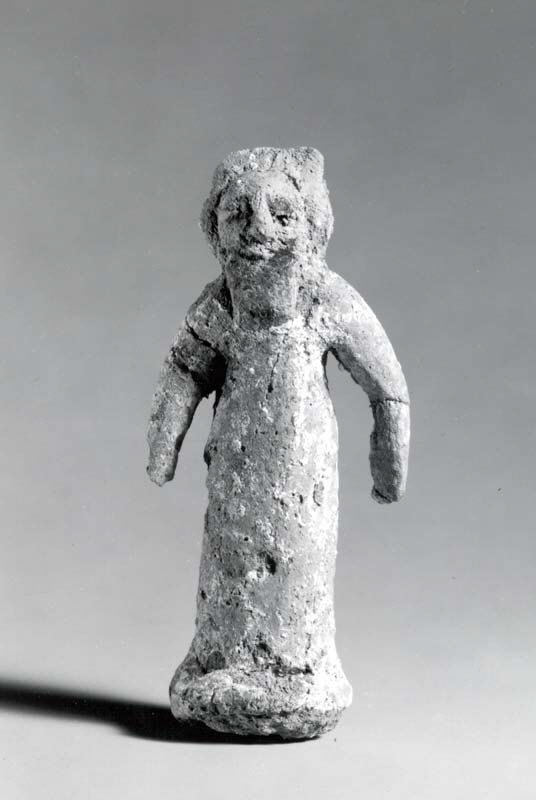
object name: sculpture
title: Figurine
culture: assyrian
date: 700-601 BCE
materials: ceramic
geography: mesopotamia